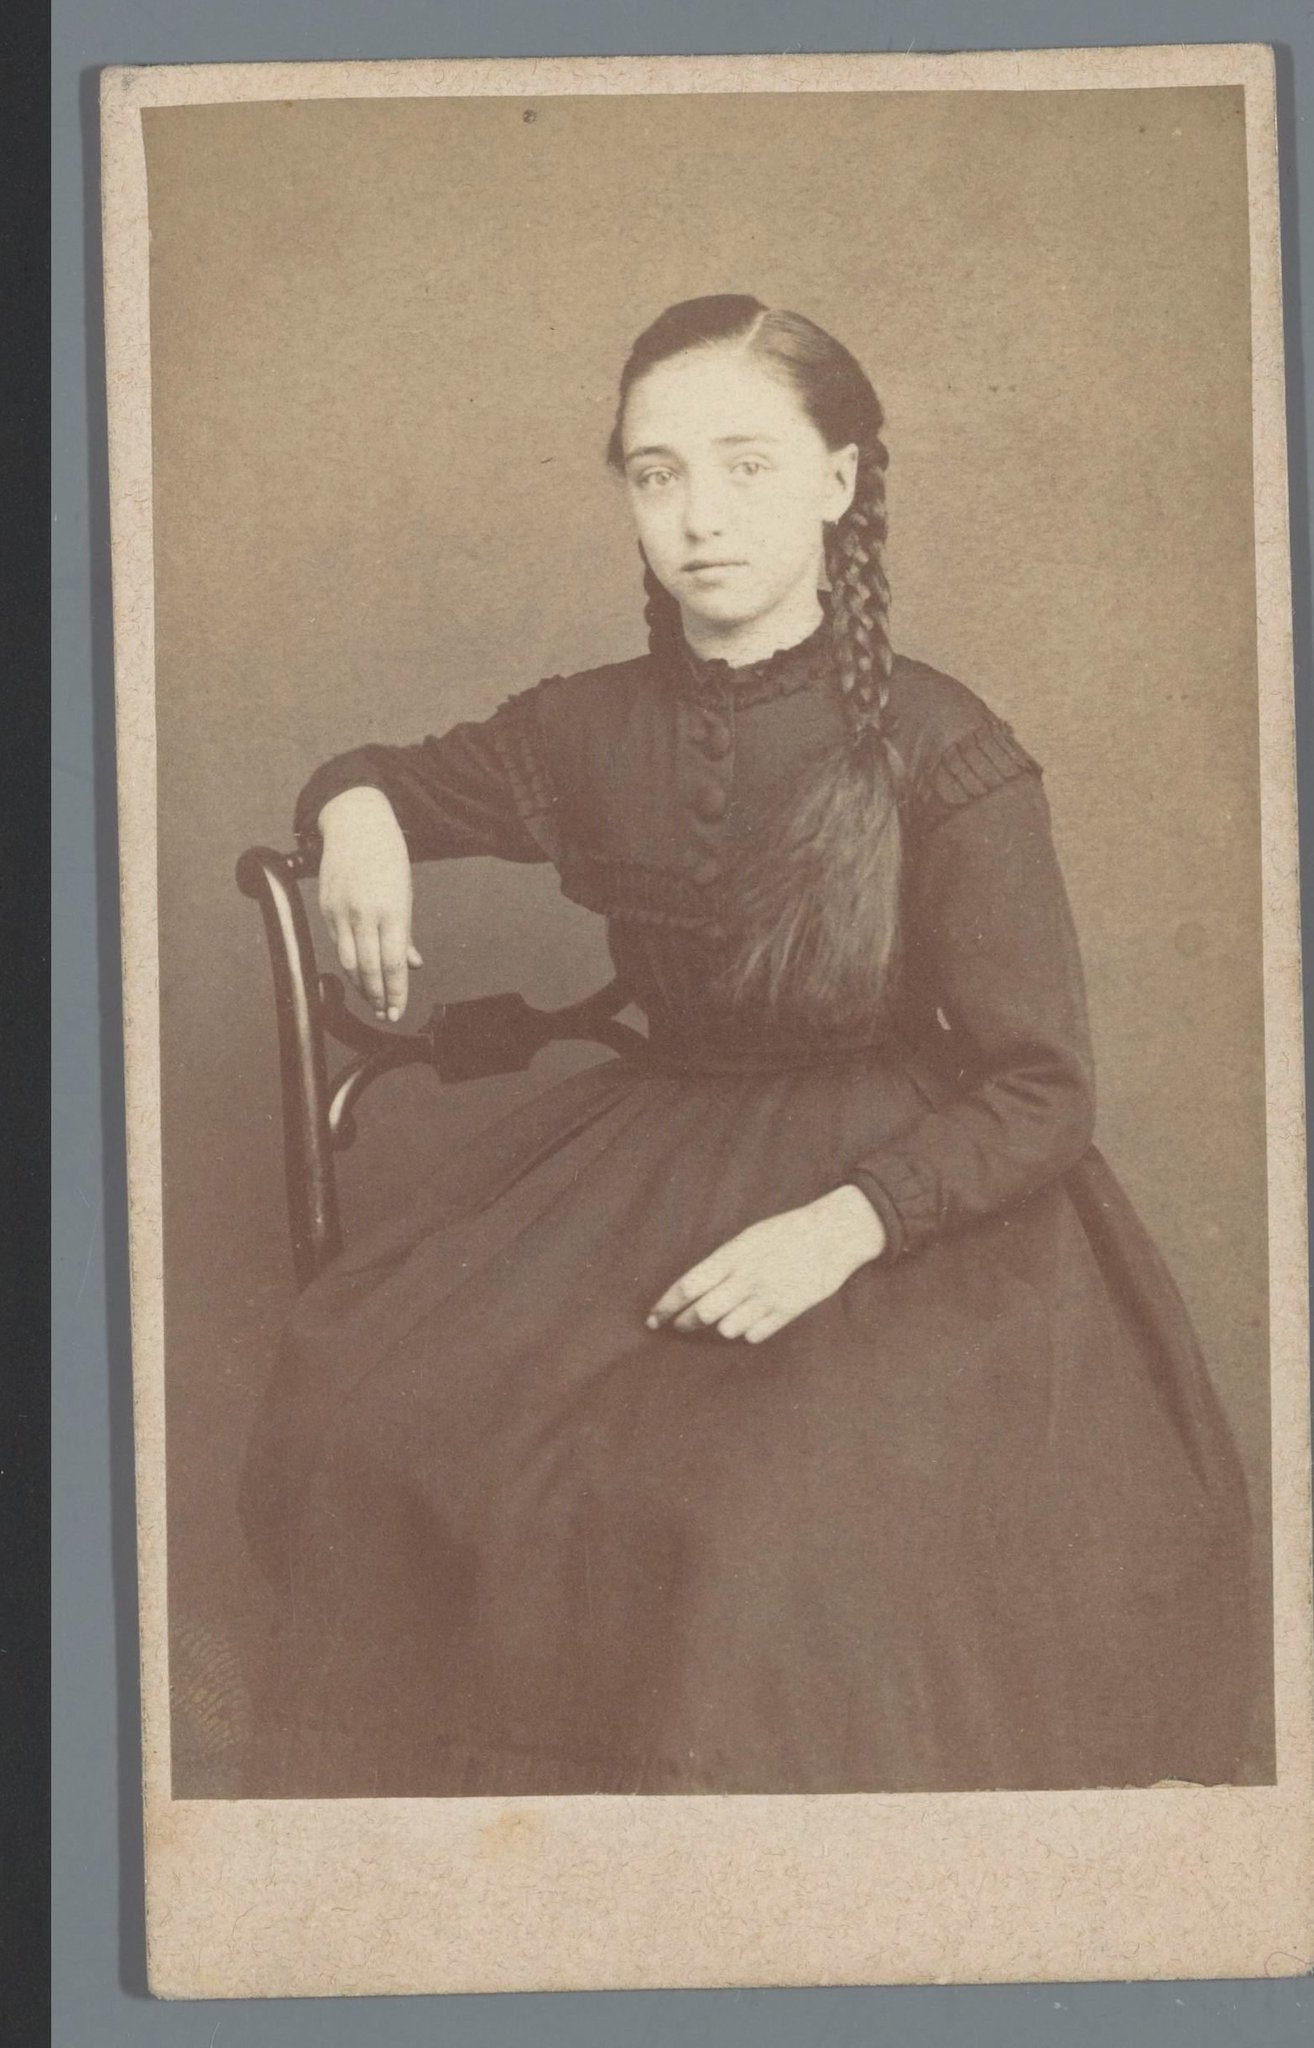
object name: carte de visite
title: Portret van een meisje, aangeduid als Emy Lauers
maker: Anonymous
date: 1870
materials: cardboard, paper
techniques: albumen print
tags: historical persons, girl (child between toddler and youth)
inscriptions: inscription: ‘Tillhoï/ Emy Lauers D[...]/ [...]/ 1870 [?]’, inscription: ‘[...]’